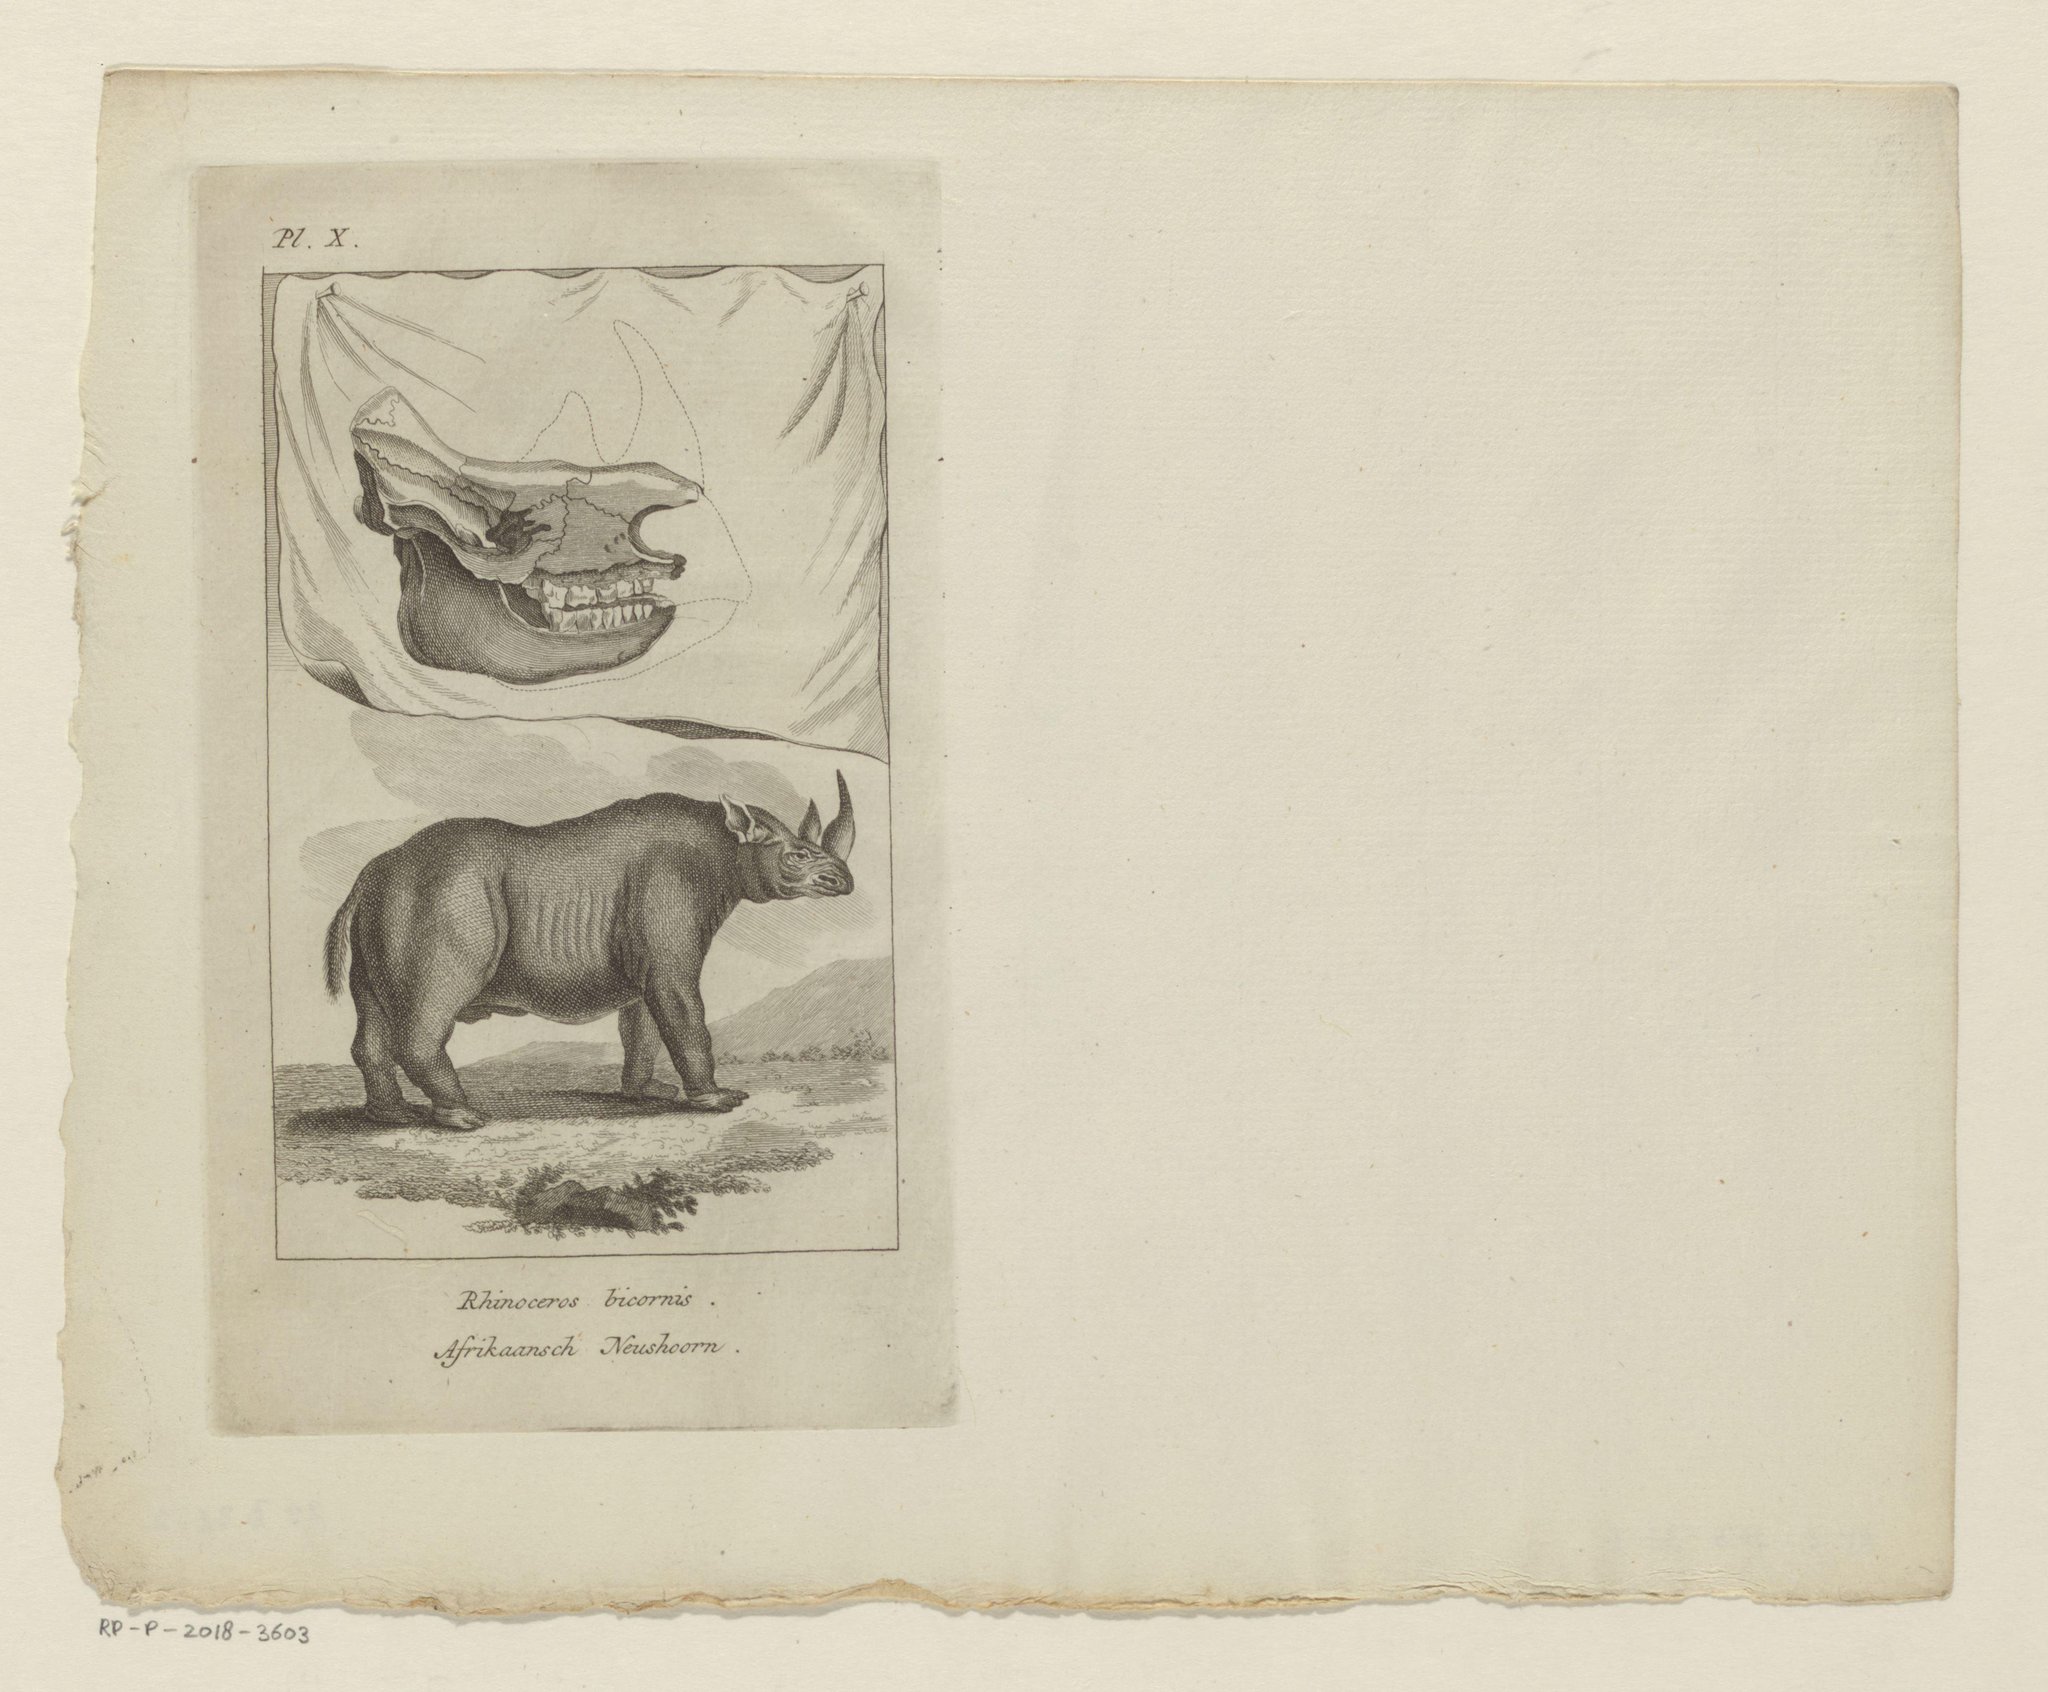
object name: print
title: Zwarte neushoorn en schedel van een zwarte neushoorn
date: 1787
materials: paper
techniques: engraving, etching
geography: netherlands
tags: hoofed animals: rhinoceros, animals (+ skull of an animal)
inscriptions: collector's mark: Lugt 2228